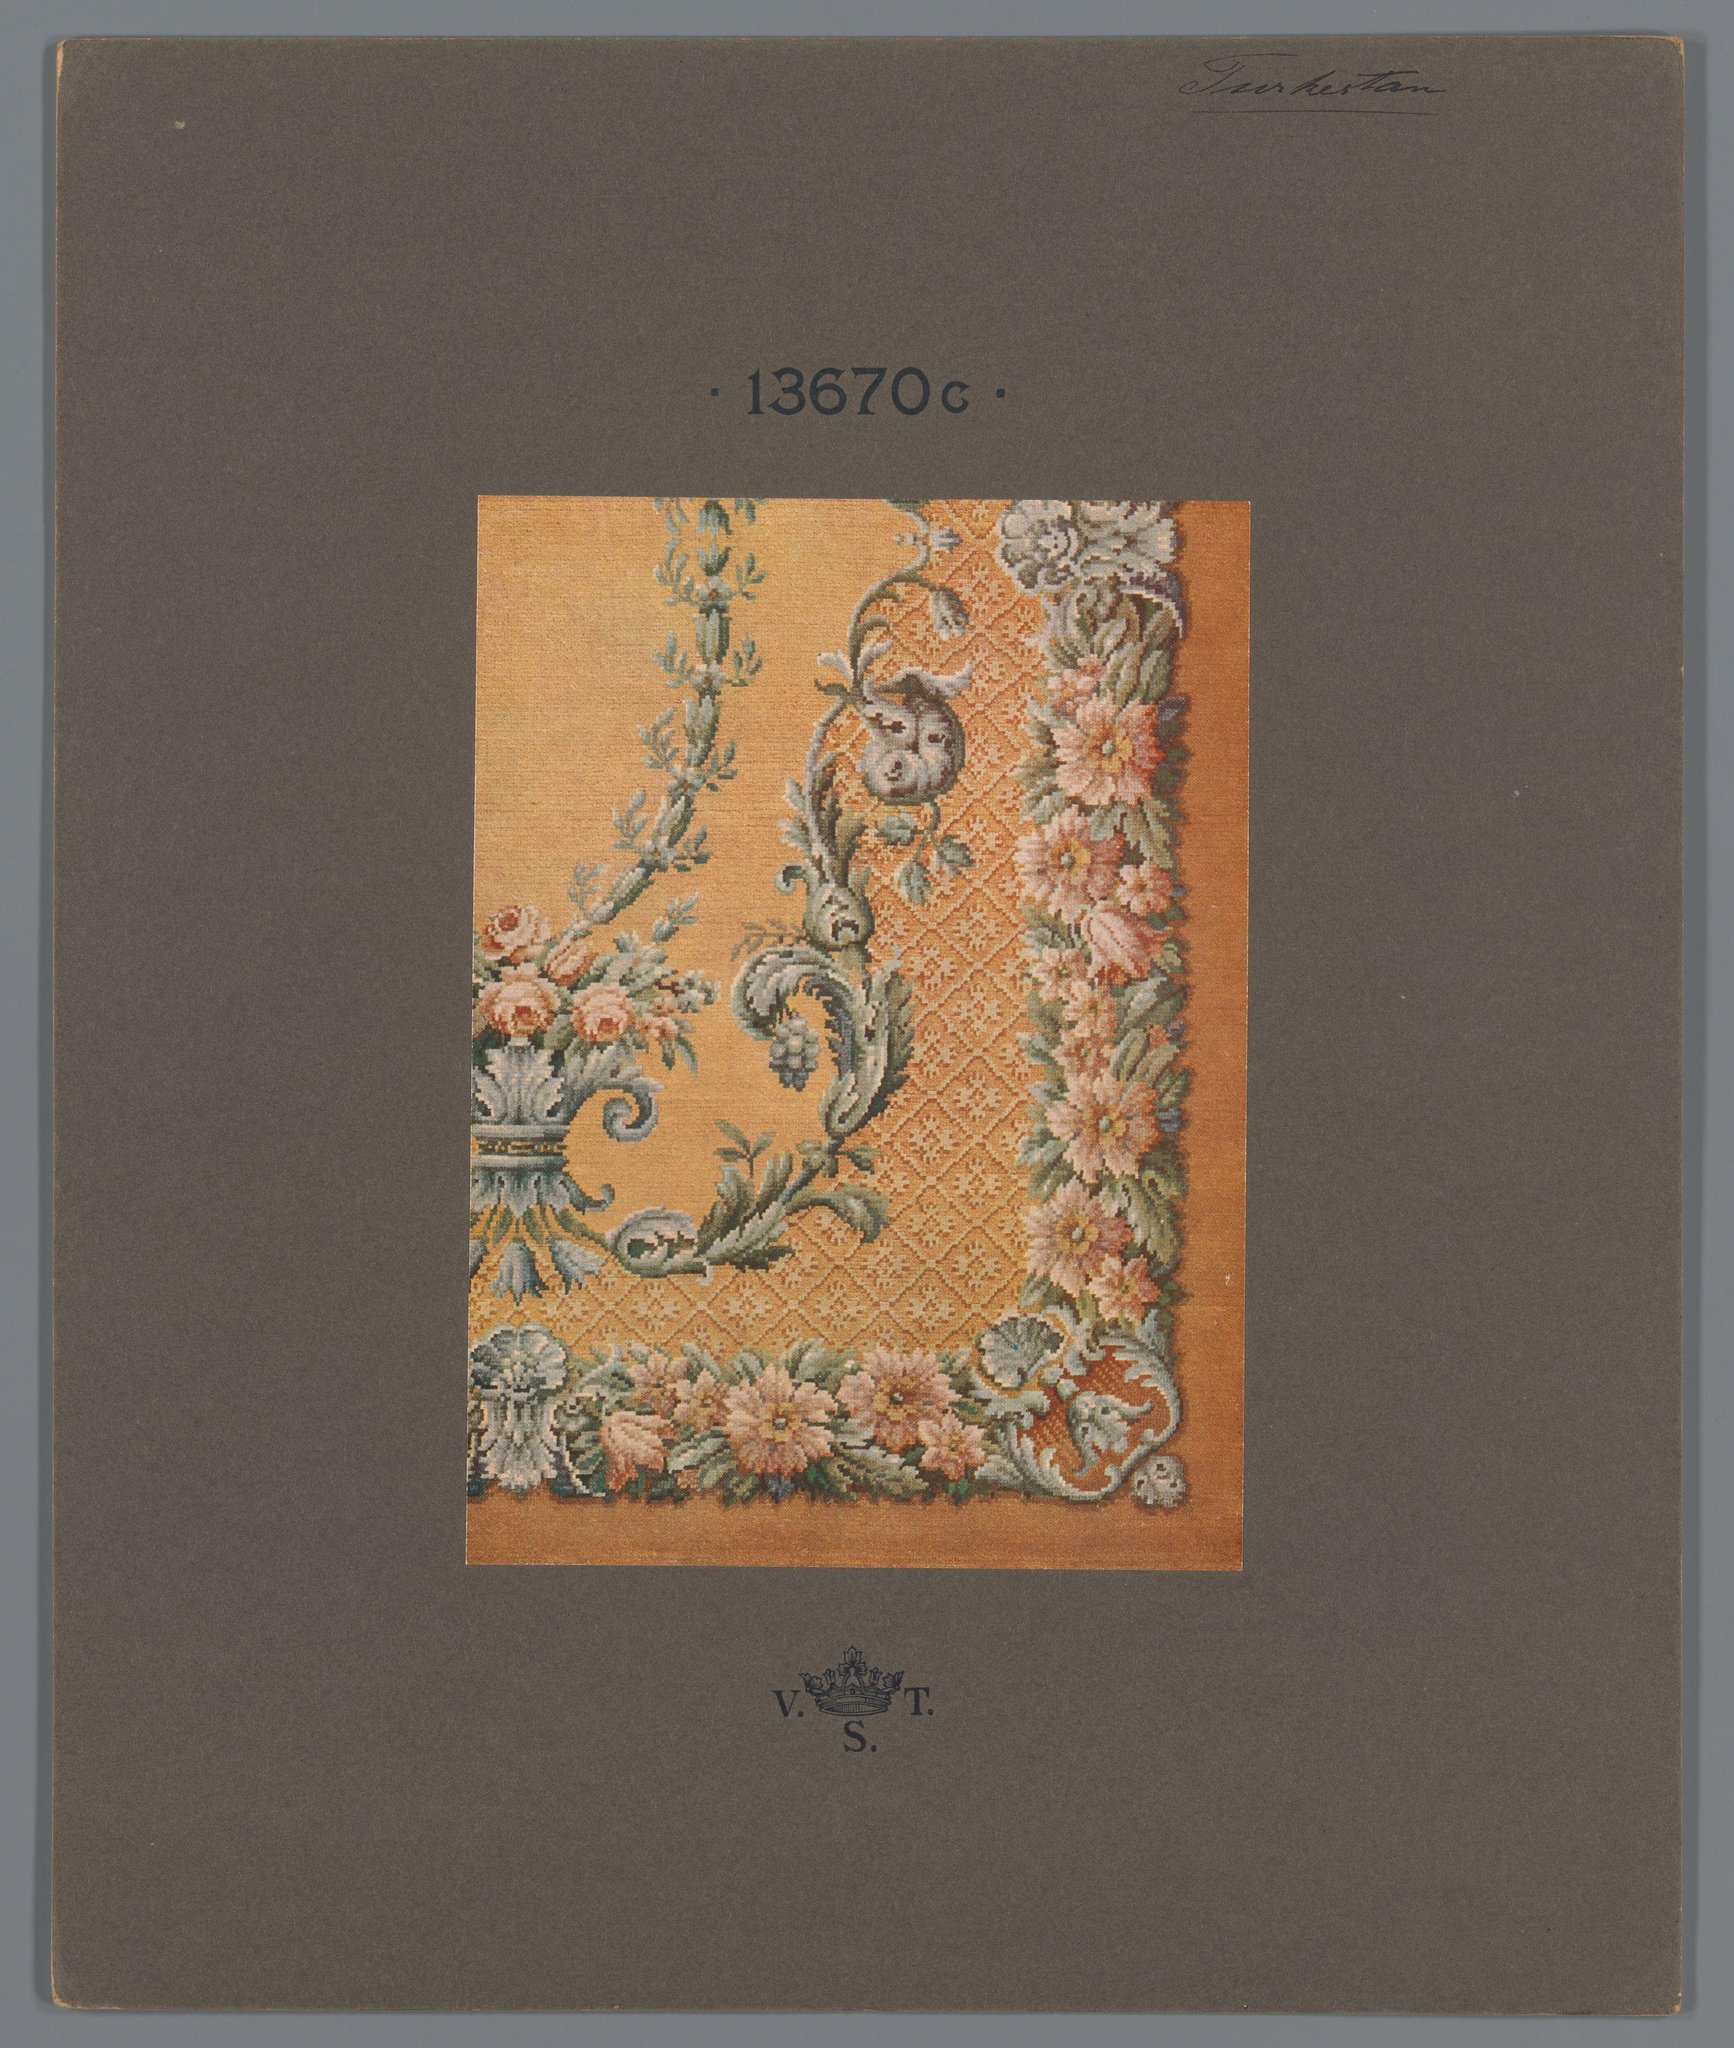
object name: photomechanical print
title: Deel van een tapijt met bloemen- en bladpatroon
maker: Anonymous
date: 1907-1929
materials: cardboard, paper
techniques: autotype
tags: fantasy ornament, carpet, rug, foliage, tendrils, branches ~ ornament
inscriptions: mark: ‘V.T.S.’, annotation: ‘Turkestan’, number: ‘.13670c.’